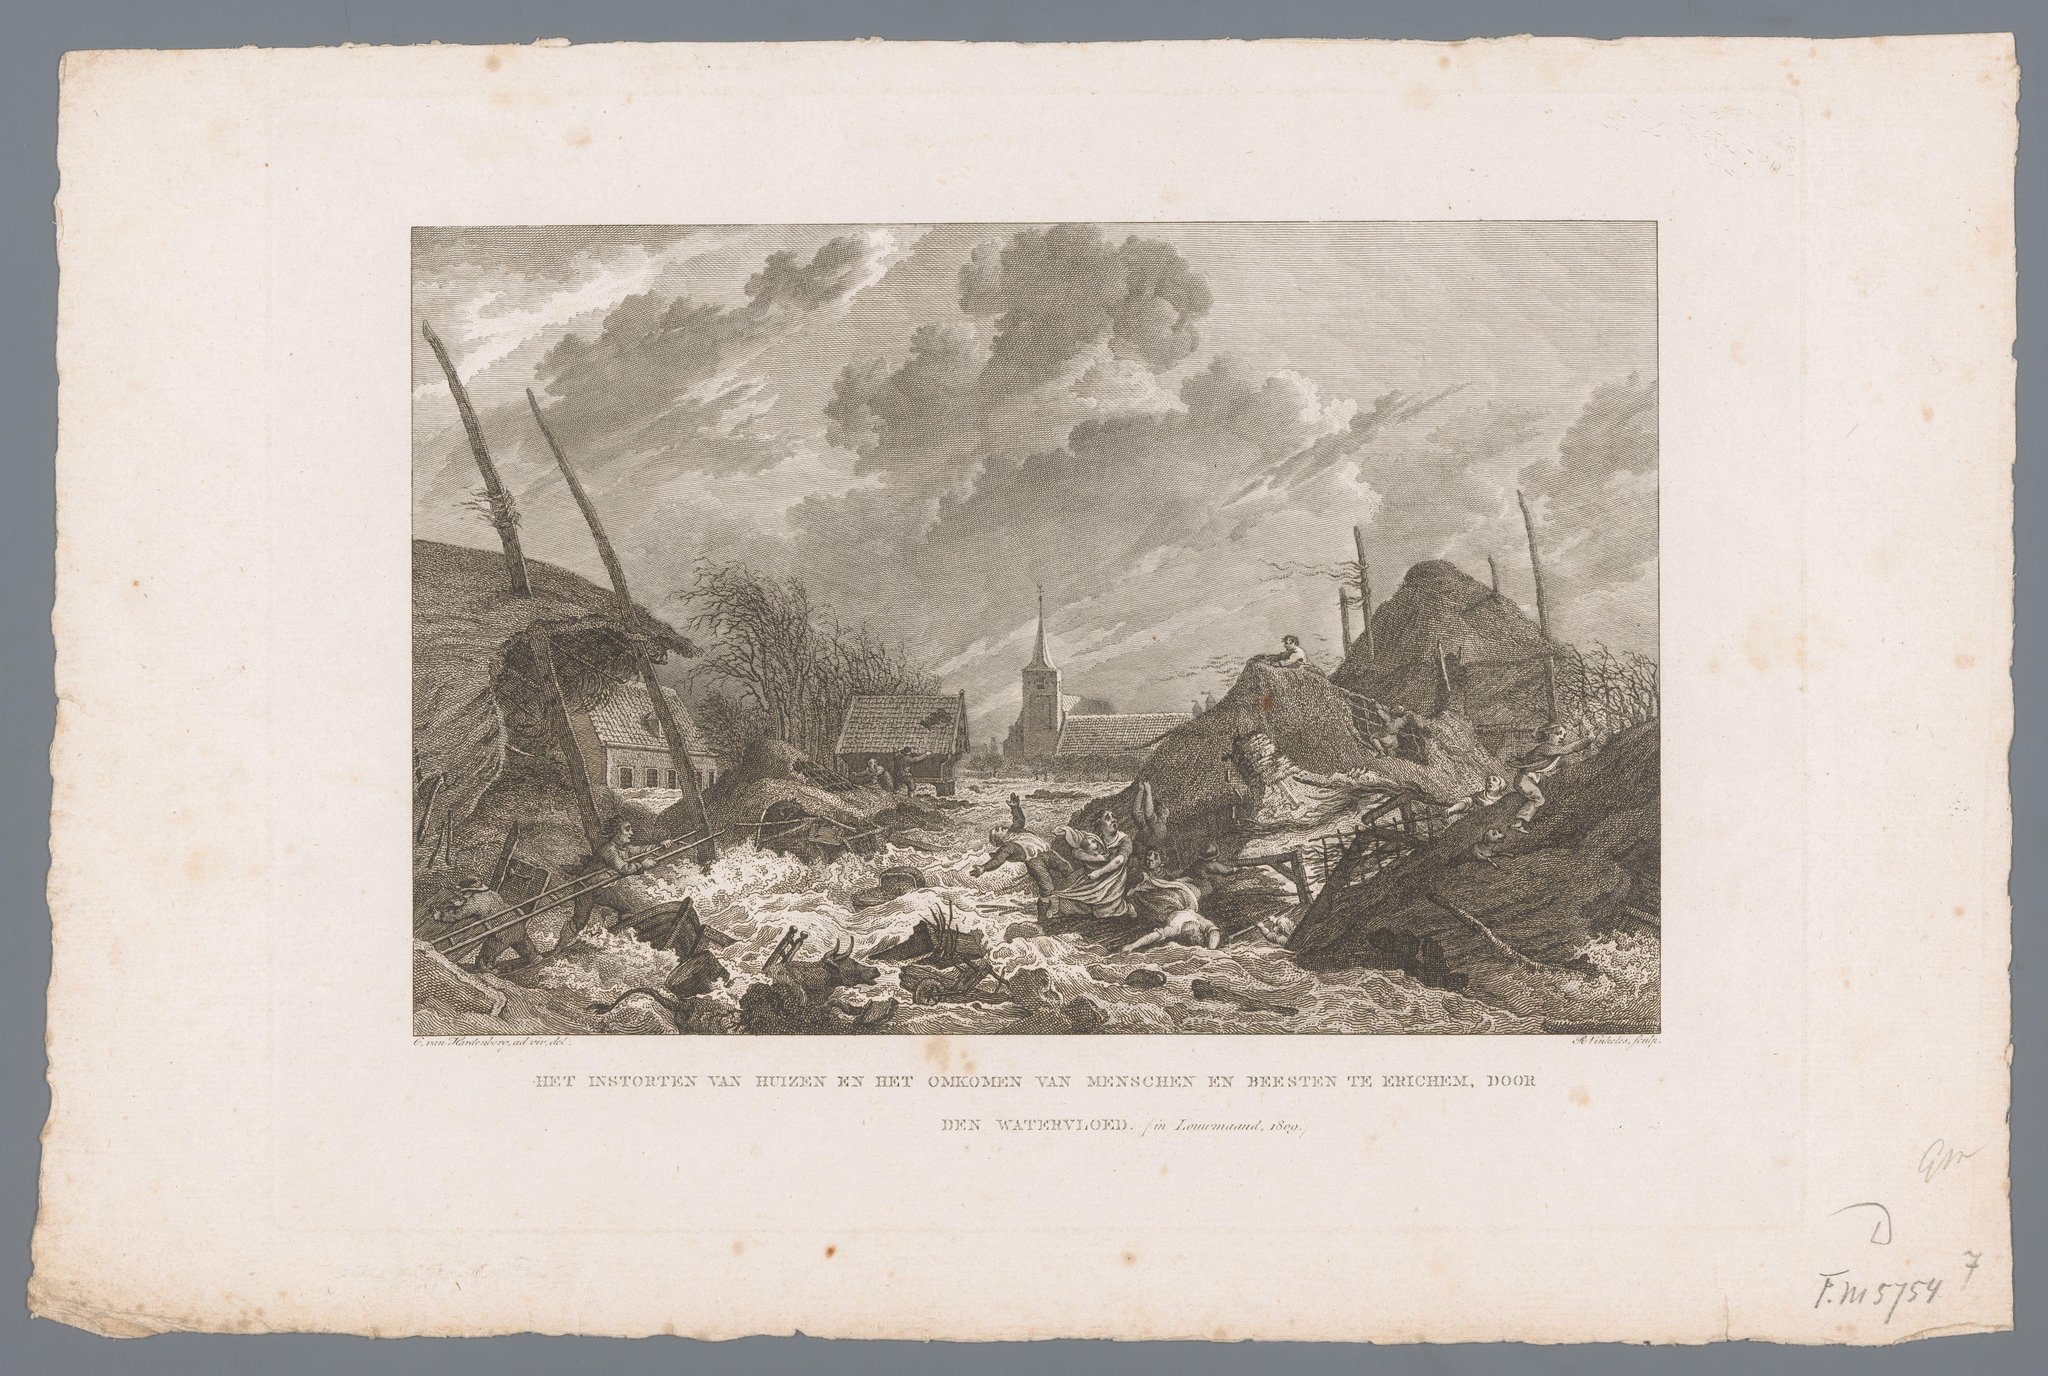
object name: book illustration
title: Het instorten van huizen en het omkomen van menschen en beesten te Erichem, door den watervloed (in Louwmaand, 1809)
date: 1809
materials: paper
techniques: etching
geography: amsterdam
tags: dike-break, death by drowning (non-violent), ruin of a dwelling, house, castle, etc.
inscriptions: collector's mark: Lugt 2228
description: Prent uit: Ewijk, Hendrik. Geschiedkundig verslag der dijkbreuken en overstroomingen, langs de rivieren in het Koningrijk Holland, voorgevallen in louwmaand MDCCCIX. Amsterdam: Johannes Allart en Jacobus Ruys, 1809.